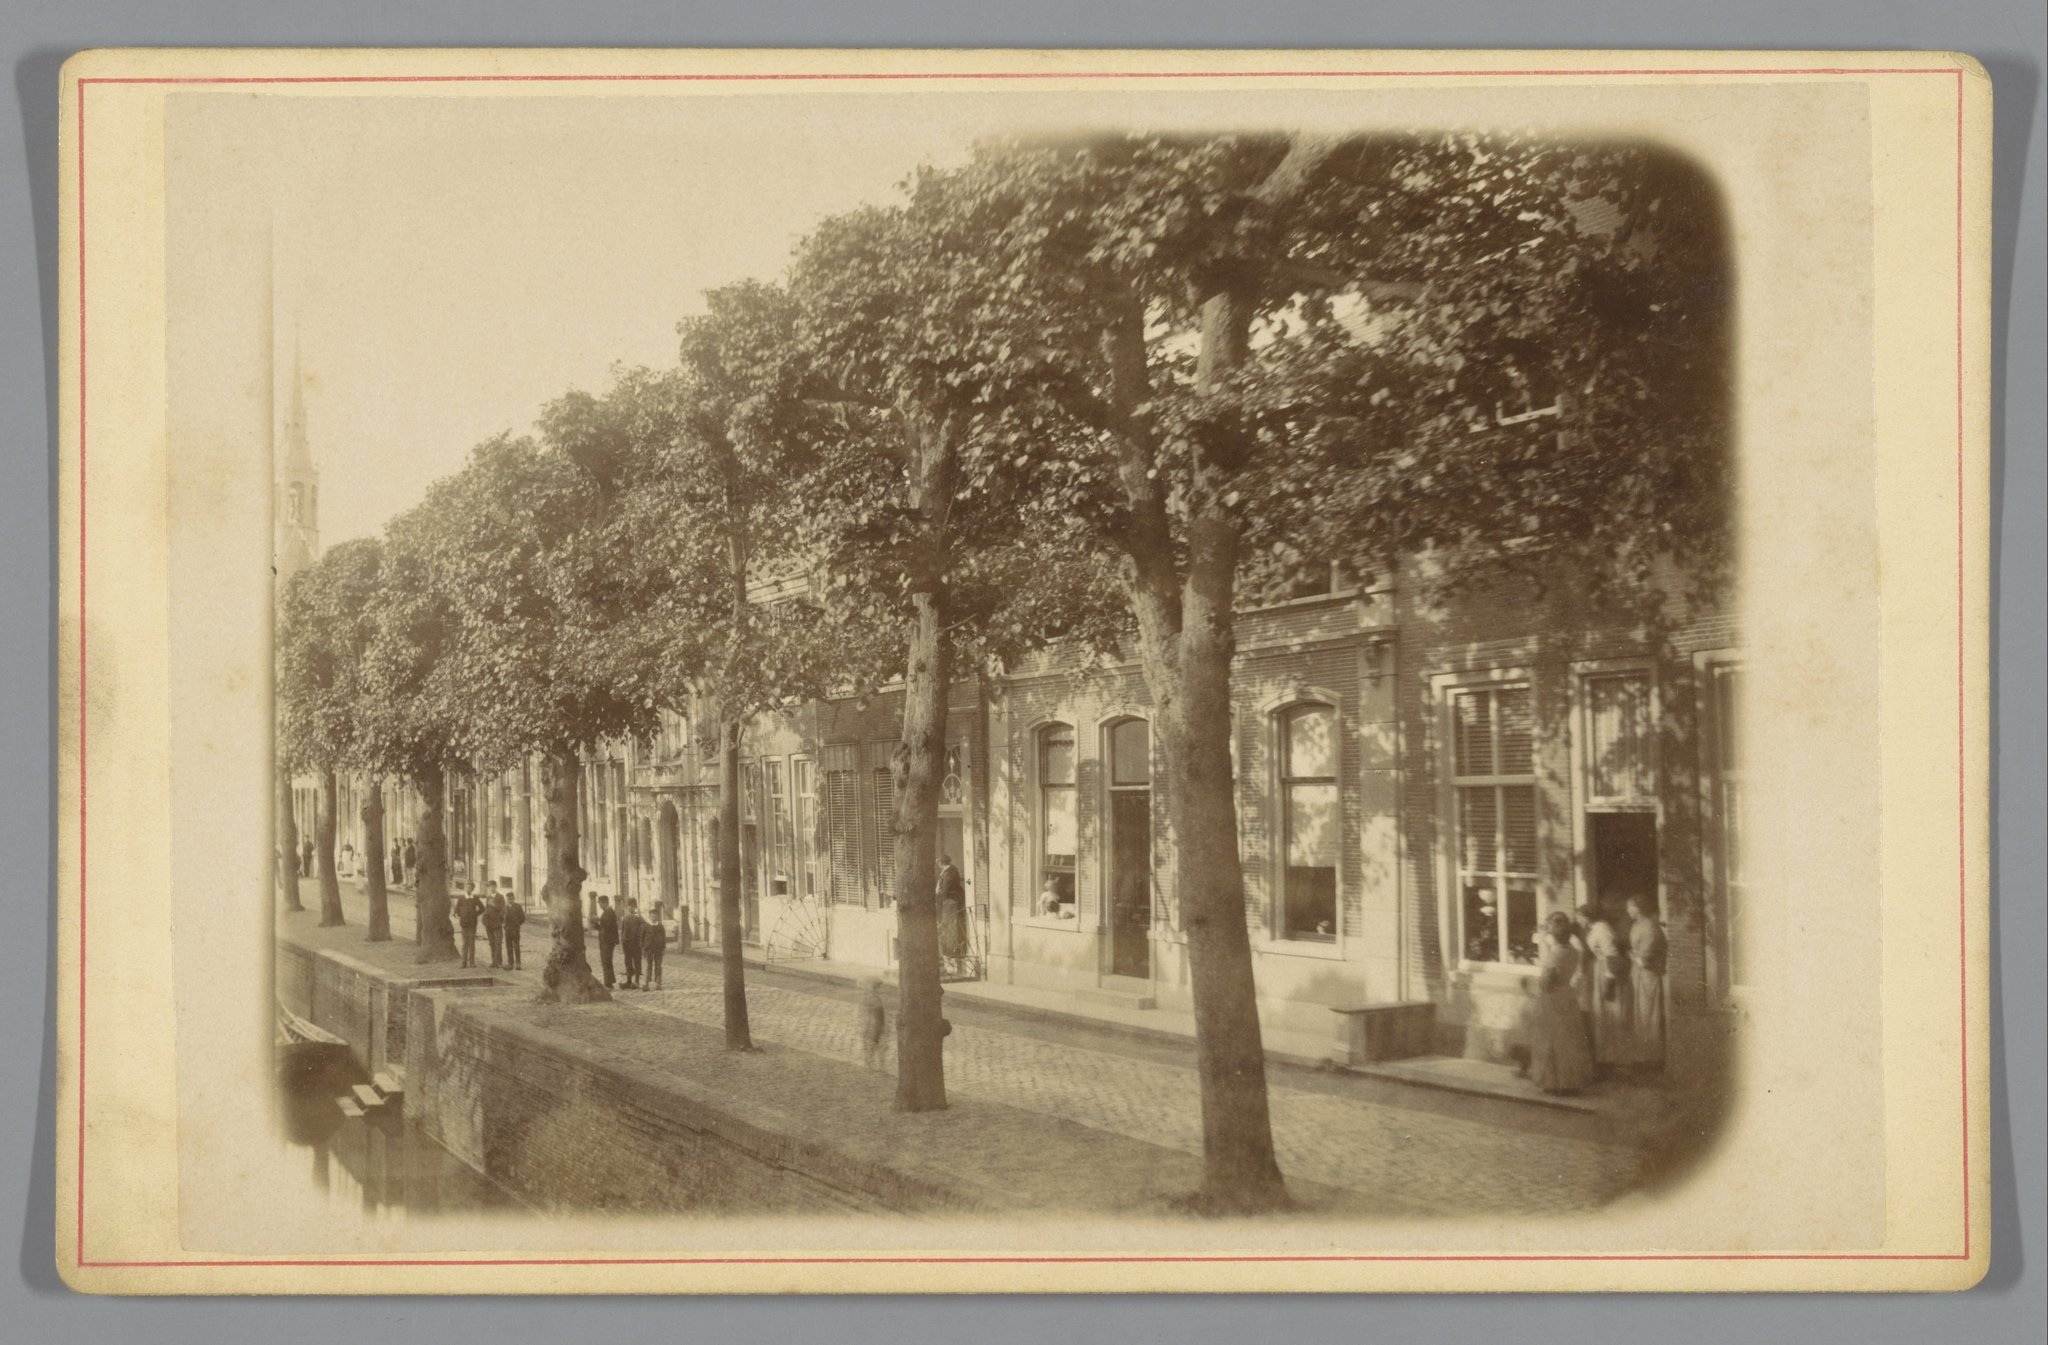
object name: cabinet photograph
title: Haven Oostzijde van de Vischbrug gezien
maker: lodewijk hendrikus serré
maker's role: fotograaf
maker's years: 1847-1897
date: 1882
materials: cardboard, paper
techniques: albumen print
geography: schoonhoven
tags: canals, waters (in city)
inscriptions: stamp: ‘S. & W. N. van Nooten/ Boekhandel/ Schoonhoven’, inscription: ‘L H Serré Utrecht’, collector's mark: ‘Vosmaer’